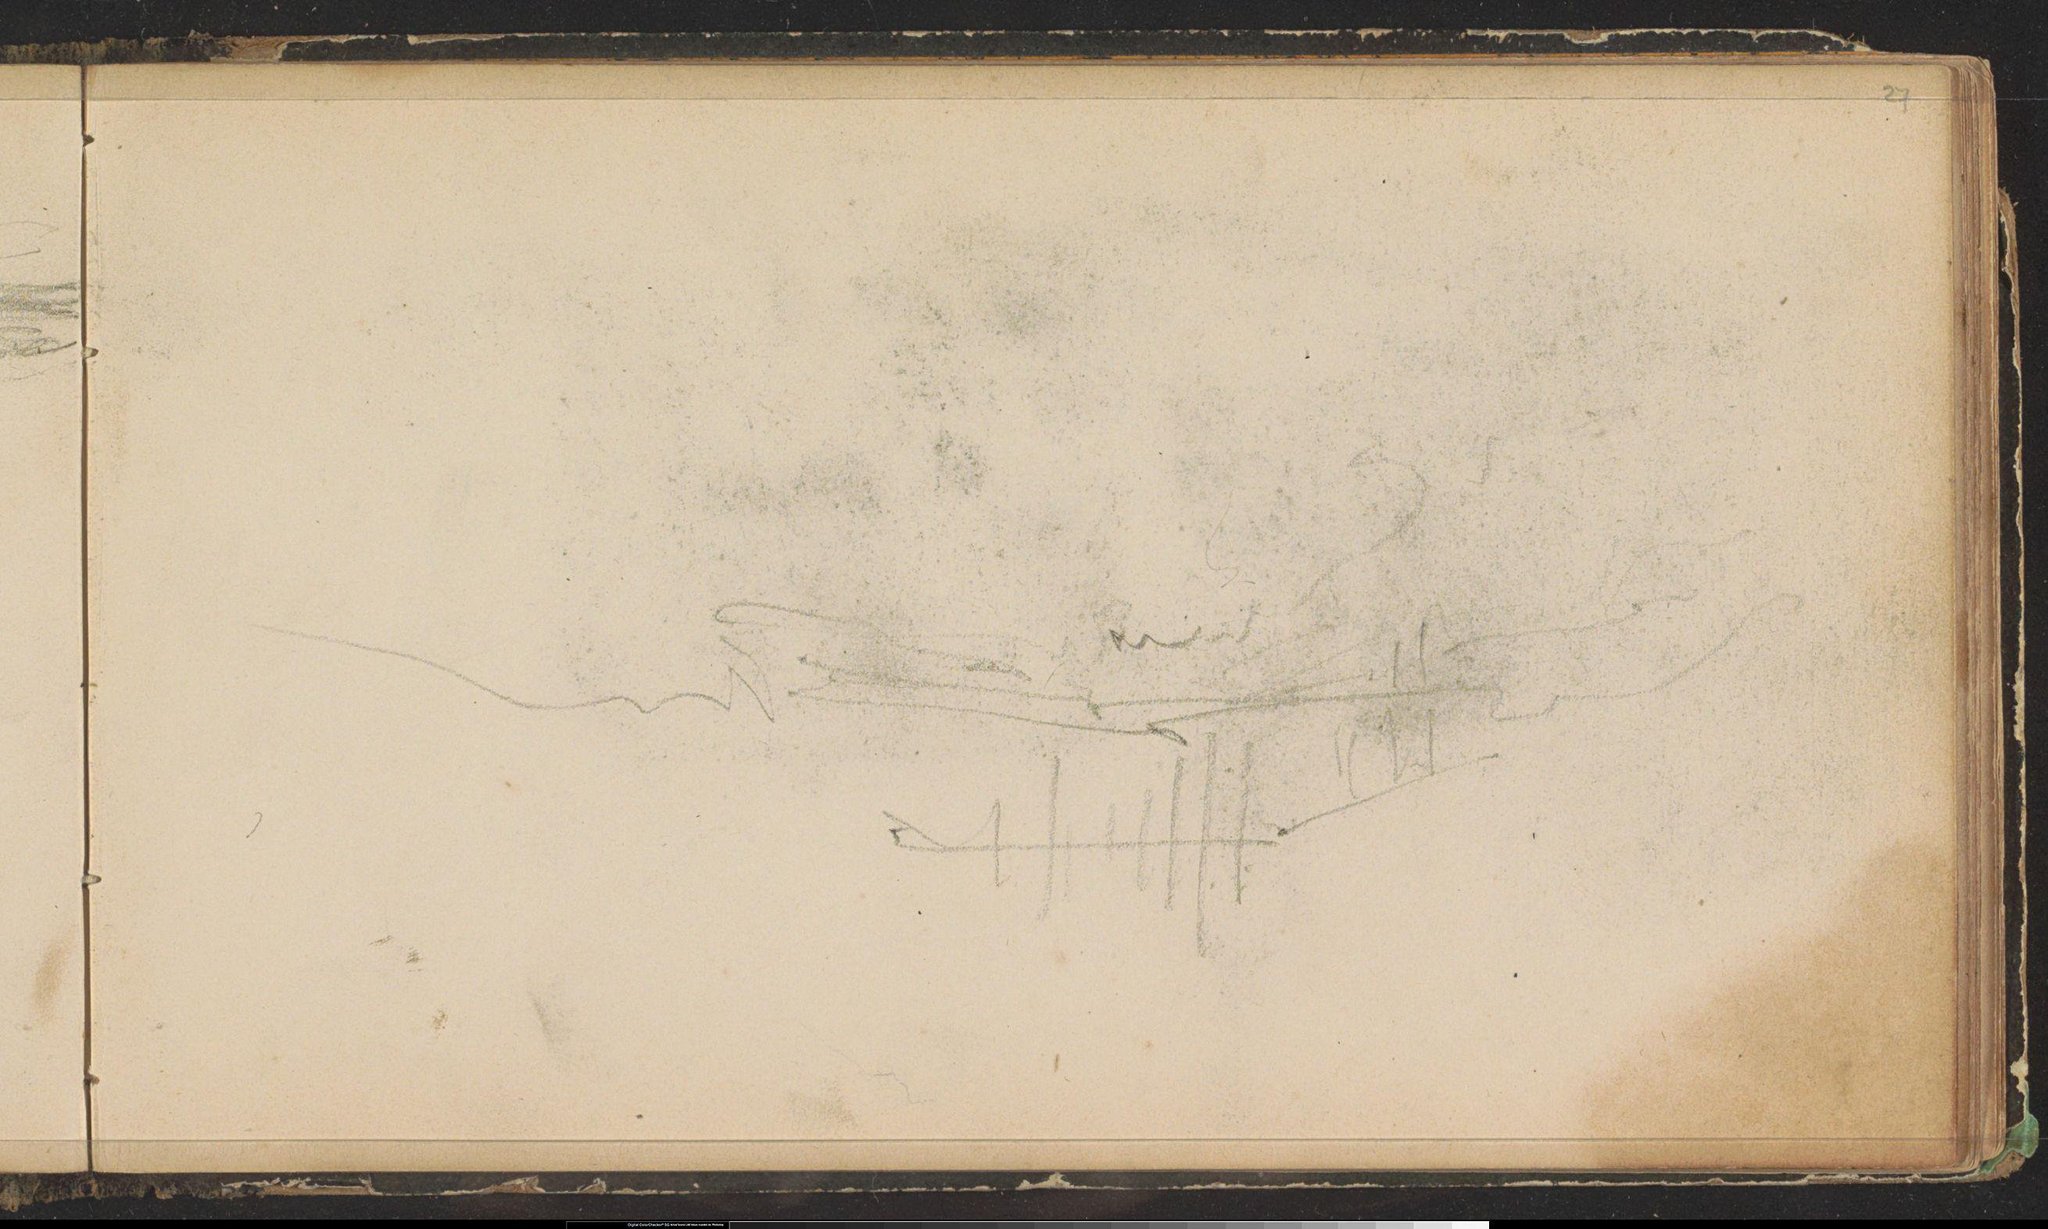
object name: sketchbook leaf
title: Studie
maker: johannes bosboom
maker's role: draughtsman, painter, print maker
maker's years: 1817-1891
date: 1845-1891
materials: paper, pencil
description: Blad 27 recto uit een schetsboek met 46 bladen.